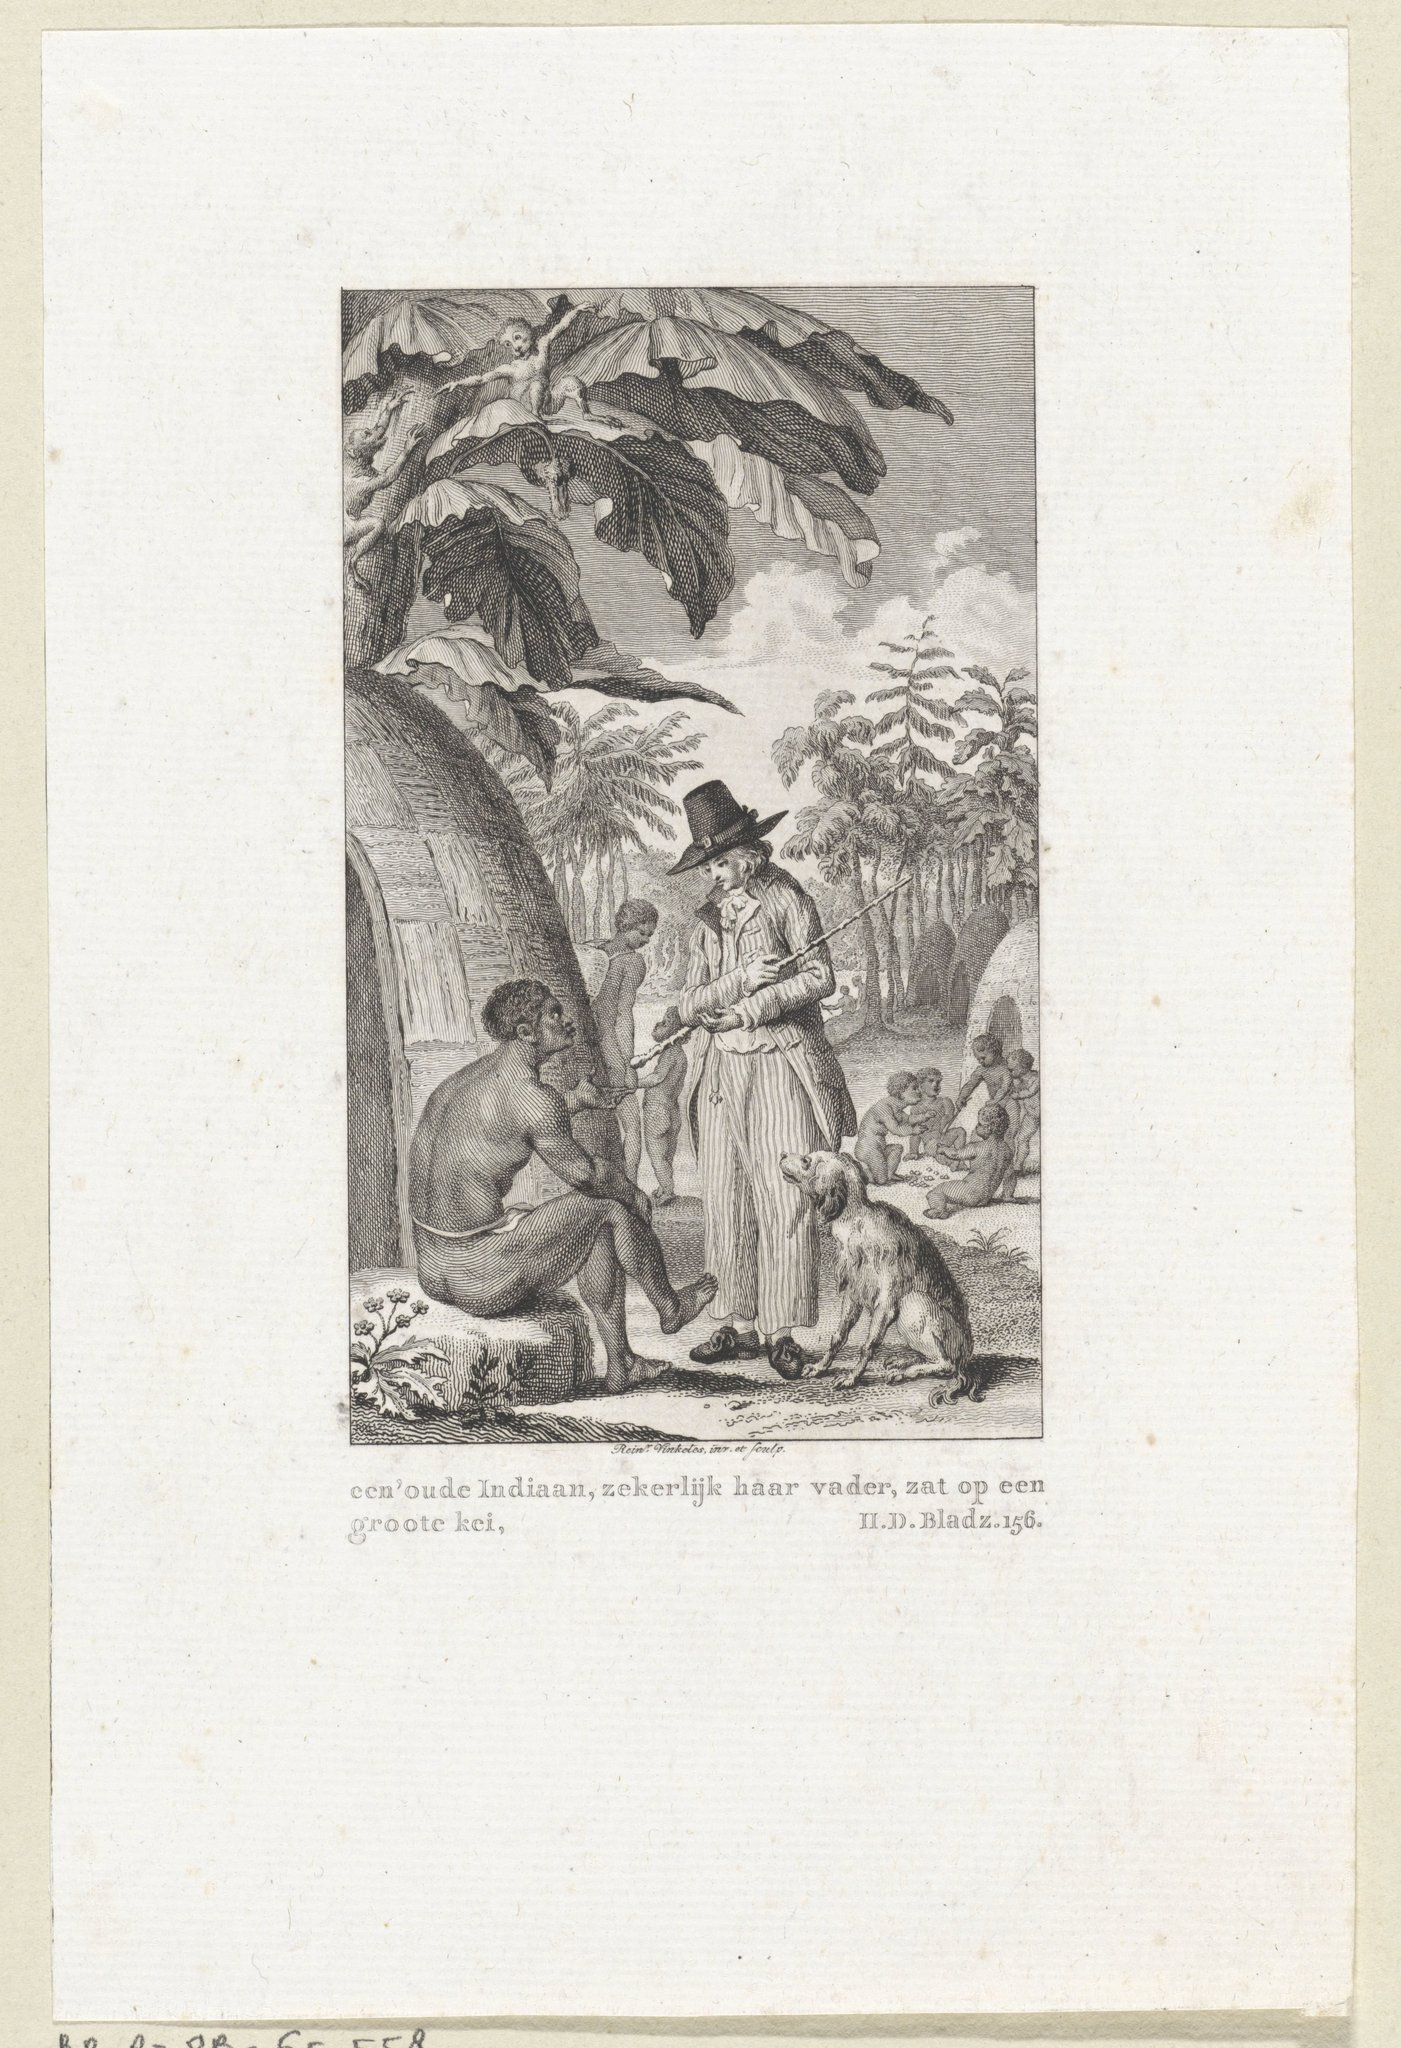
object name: book illustration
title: Reinhart en donkere man voeren een gesprek voor een hut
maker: reinier vinkeles (i)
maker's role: draughtsman, print maker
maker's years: 1741-1816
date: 1791-1798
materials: paper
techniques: engraving, etching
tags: indigenous peoples of south america, human races, peoples and nationalities (other than prehistoric or extinct), trees: palm-tree, hut, cabin, lodge, dog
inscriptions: collector's mark: Lugt 240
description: Prent gebruikt in: Post, Elisabeth Maria. Reinhart, of Natuur en Godsdienst. 3 dln. 1e druk. Amsterdam: Johannes Allart, 1791-1792, dl. 2 (1791), p. 156. En in: Post, Elisabeth Maria. Reinhart, of Natuur en Godsdienst. 3 dln. 2e druk. Amsterdam: Johannes Allart, 1798-1802, dl. 2 (1798), p. 156.